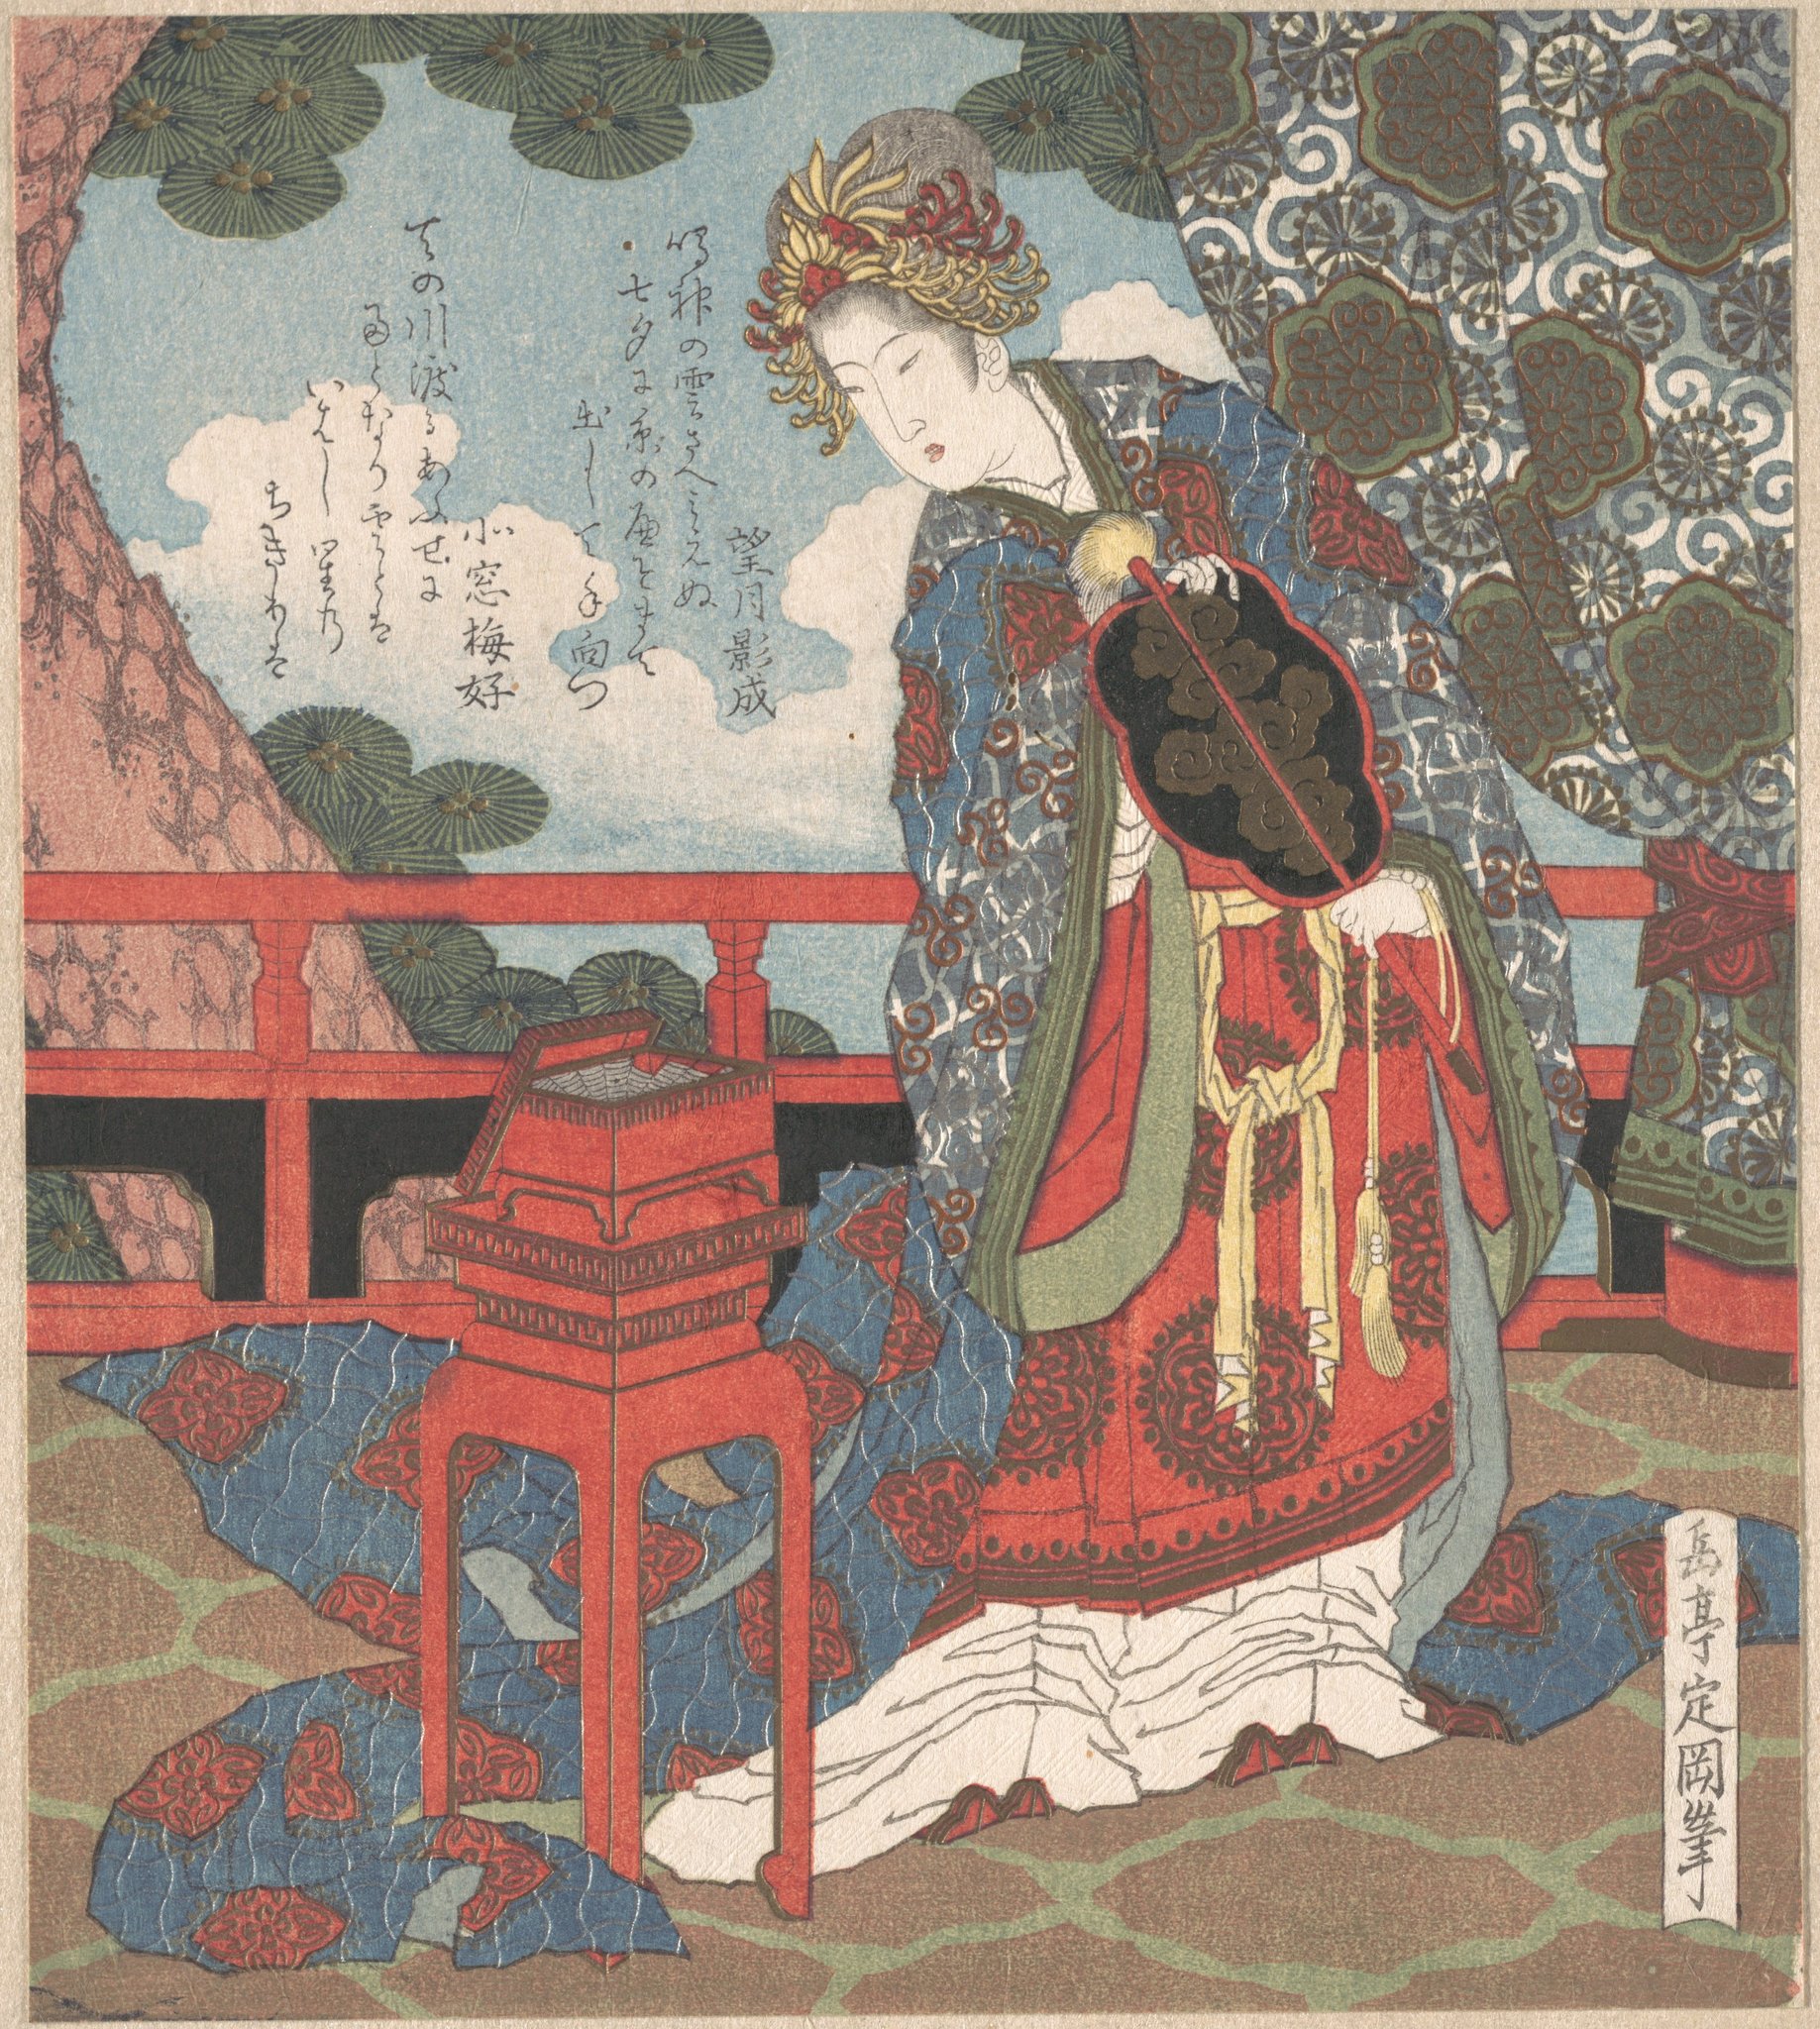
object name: print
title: Lady with Fan Standing on Verandah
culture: japanese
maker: yashima gakutei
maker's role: artist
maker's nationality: japanese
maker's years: 1786-1868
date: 1801-1900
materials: ink, paper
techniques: surimono, woodblock print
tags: fans,women,trees